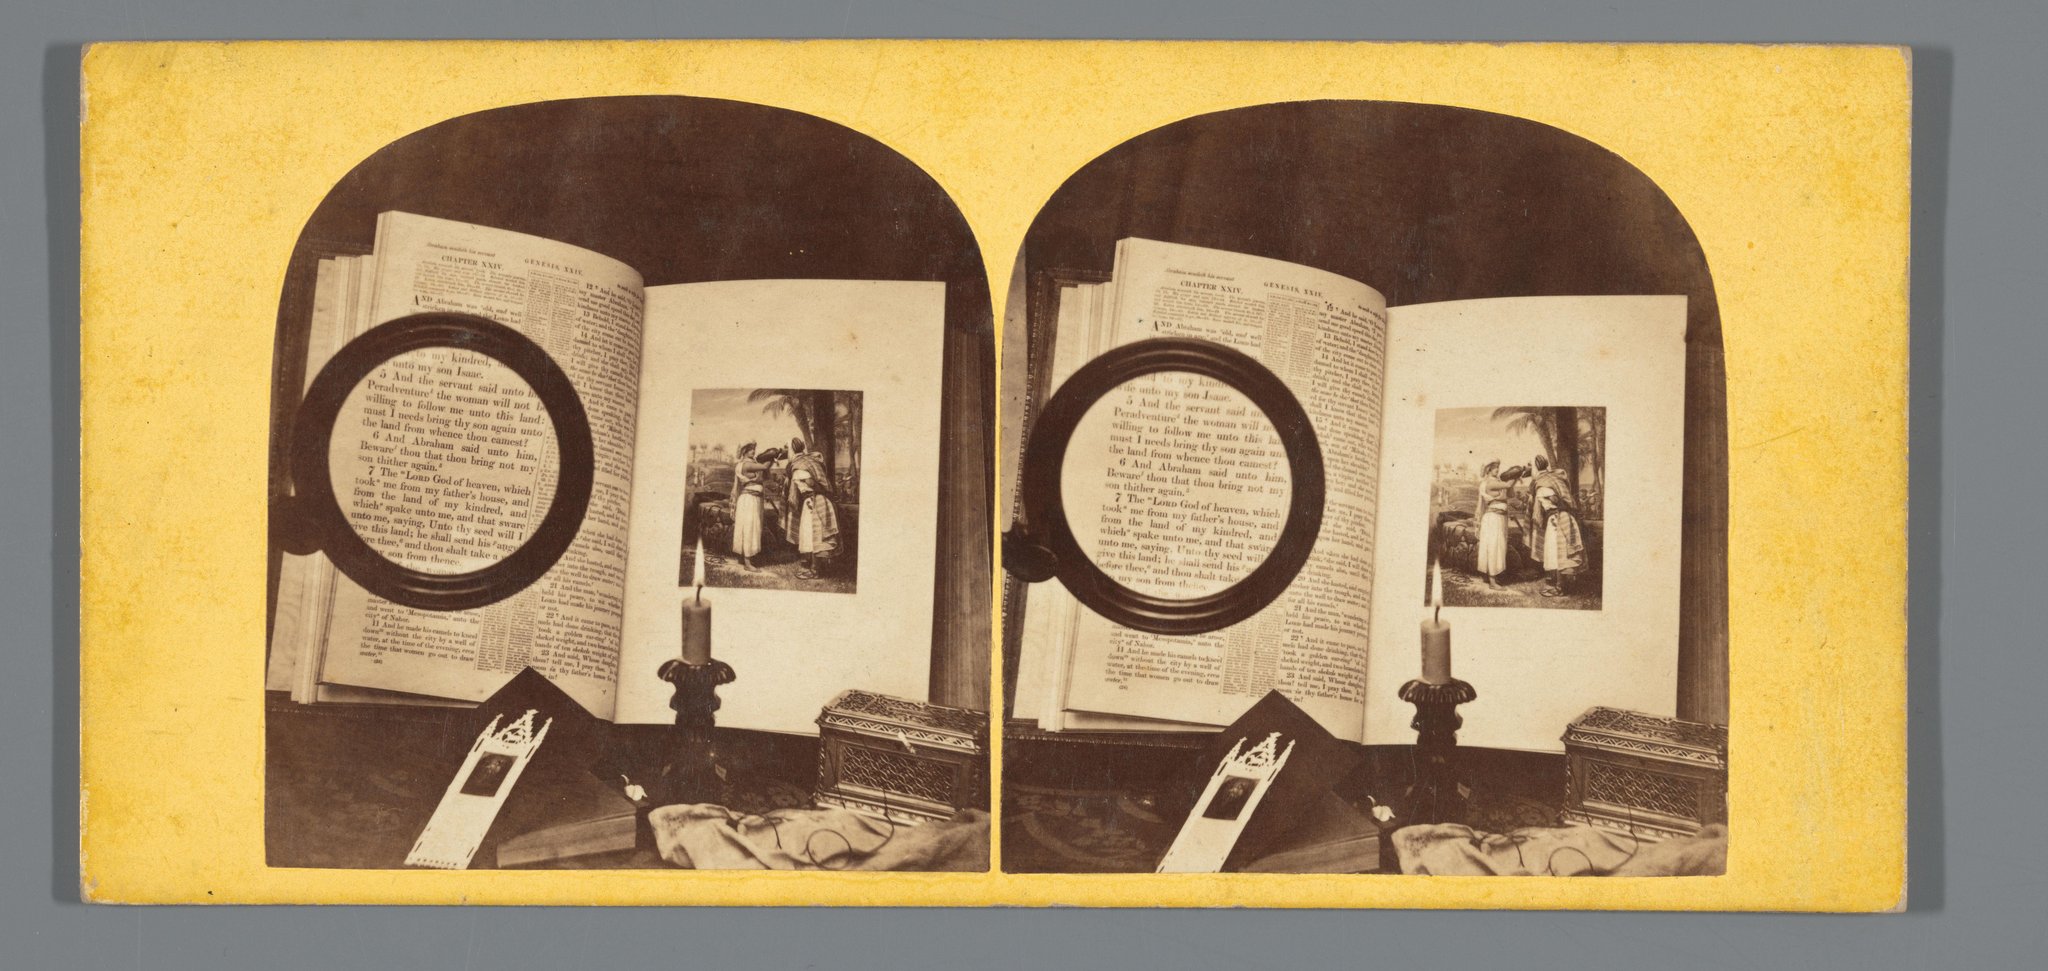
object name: stereograph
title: Still-life with a Bible, Magnifying Glass, Candle and Eyeglasses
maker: Anonymous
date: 1855-1870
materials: cardboard, photographic support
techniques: albumen print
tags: eyeglasses, spectacles, magnifying glass, candle, still life of miscellaneous objects